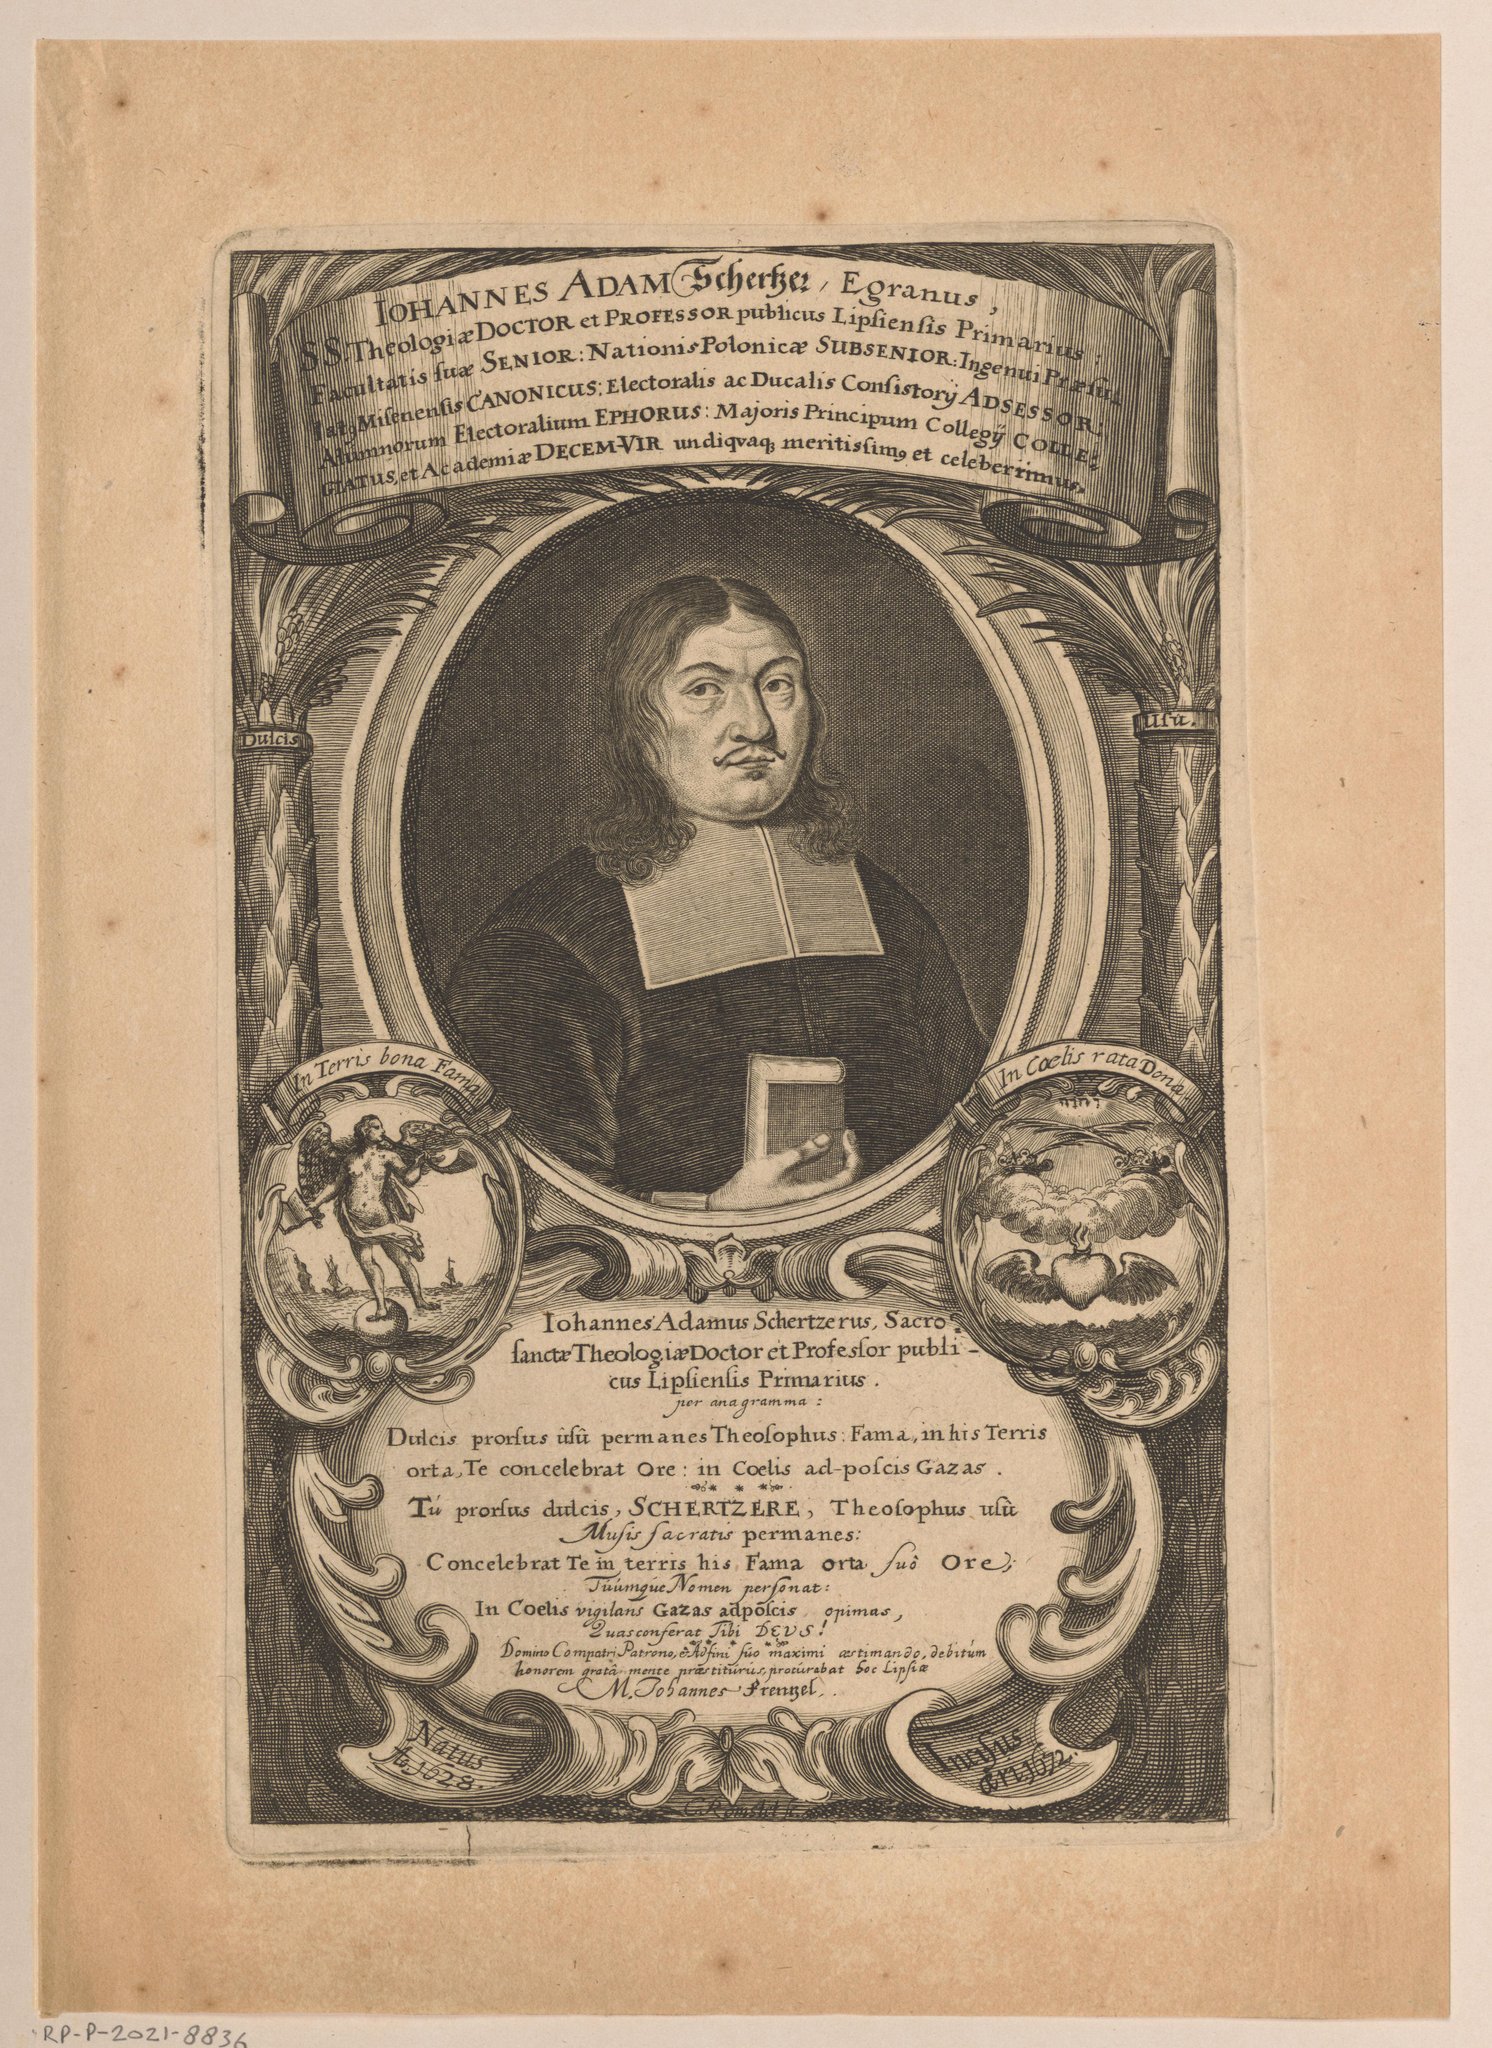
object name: print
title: Portret van Johann Adam Schertzer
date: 1672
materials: paper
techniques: engraving, etching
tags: theologian, historical persons, heart, angels